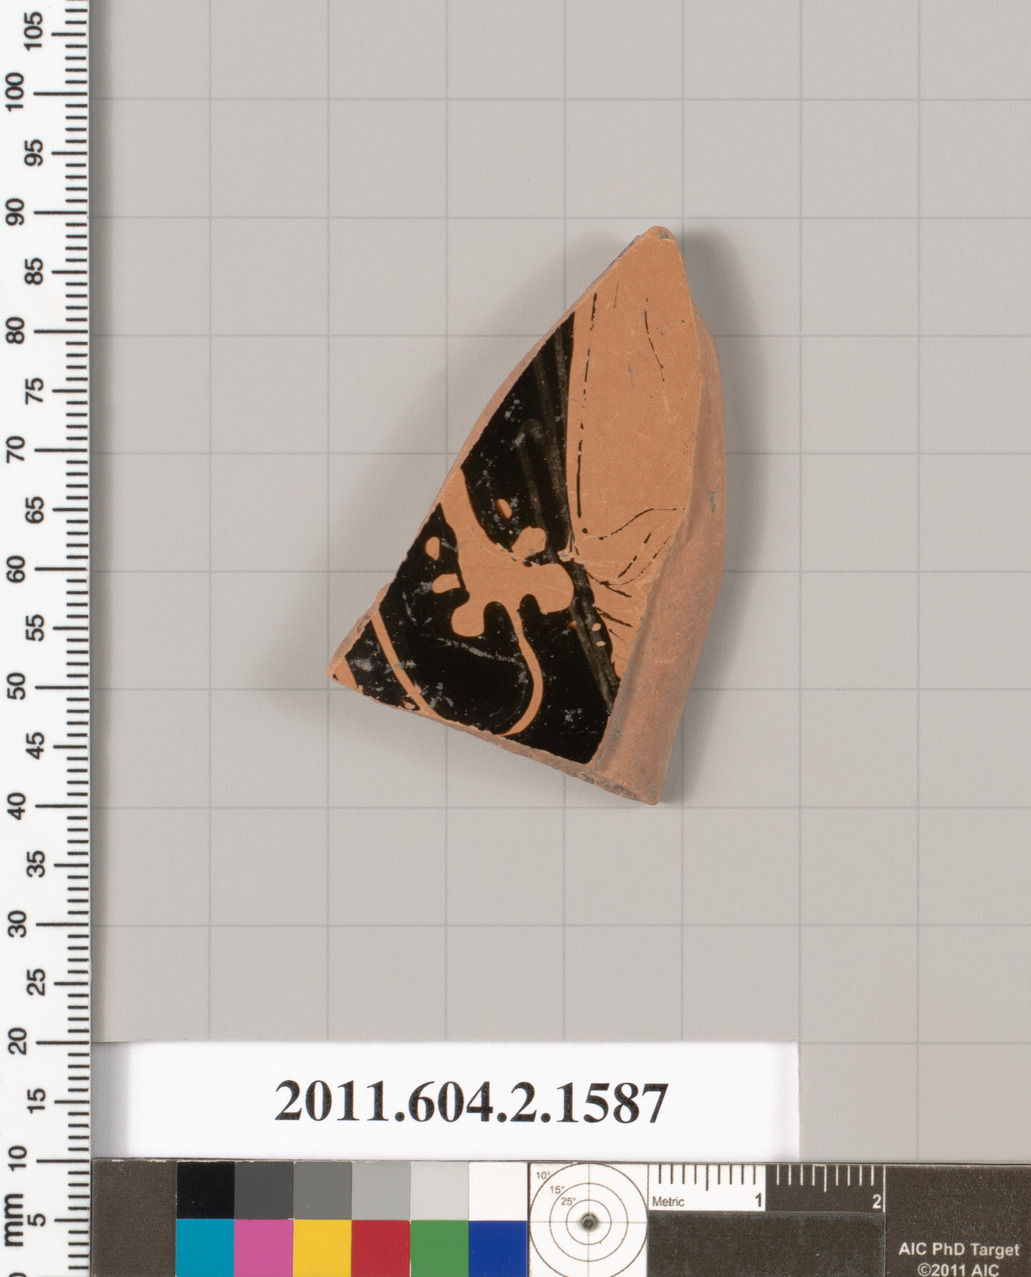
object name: skyphos fragment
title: Terracotta fragment of a skyphos (deep drinking cup)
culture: greek, attic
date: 475-451 BCE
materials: terracotta